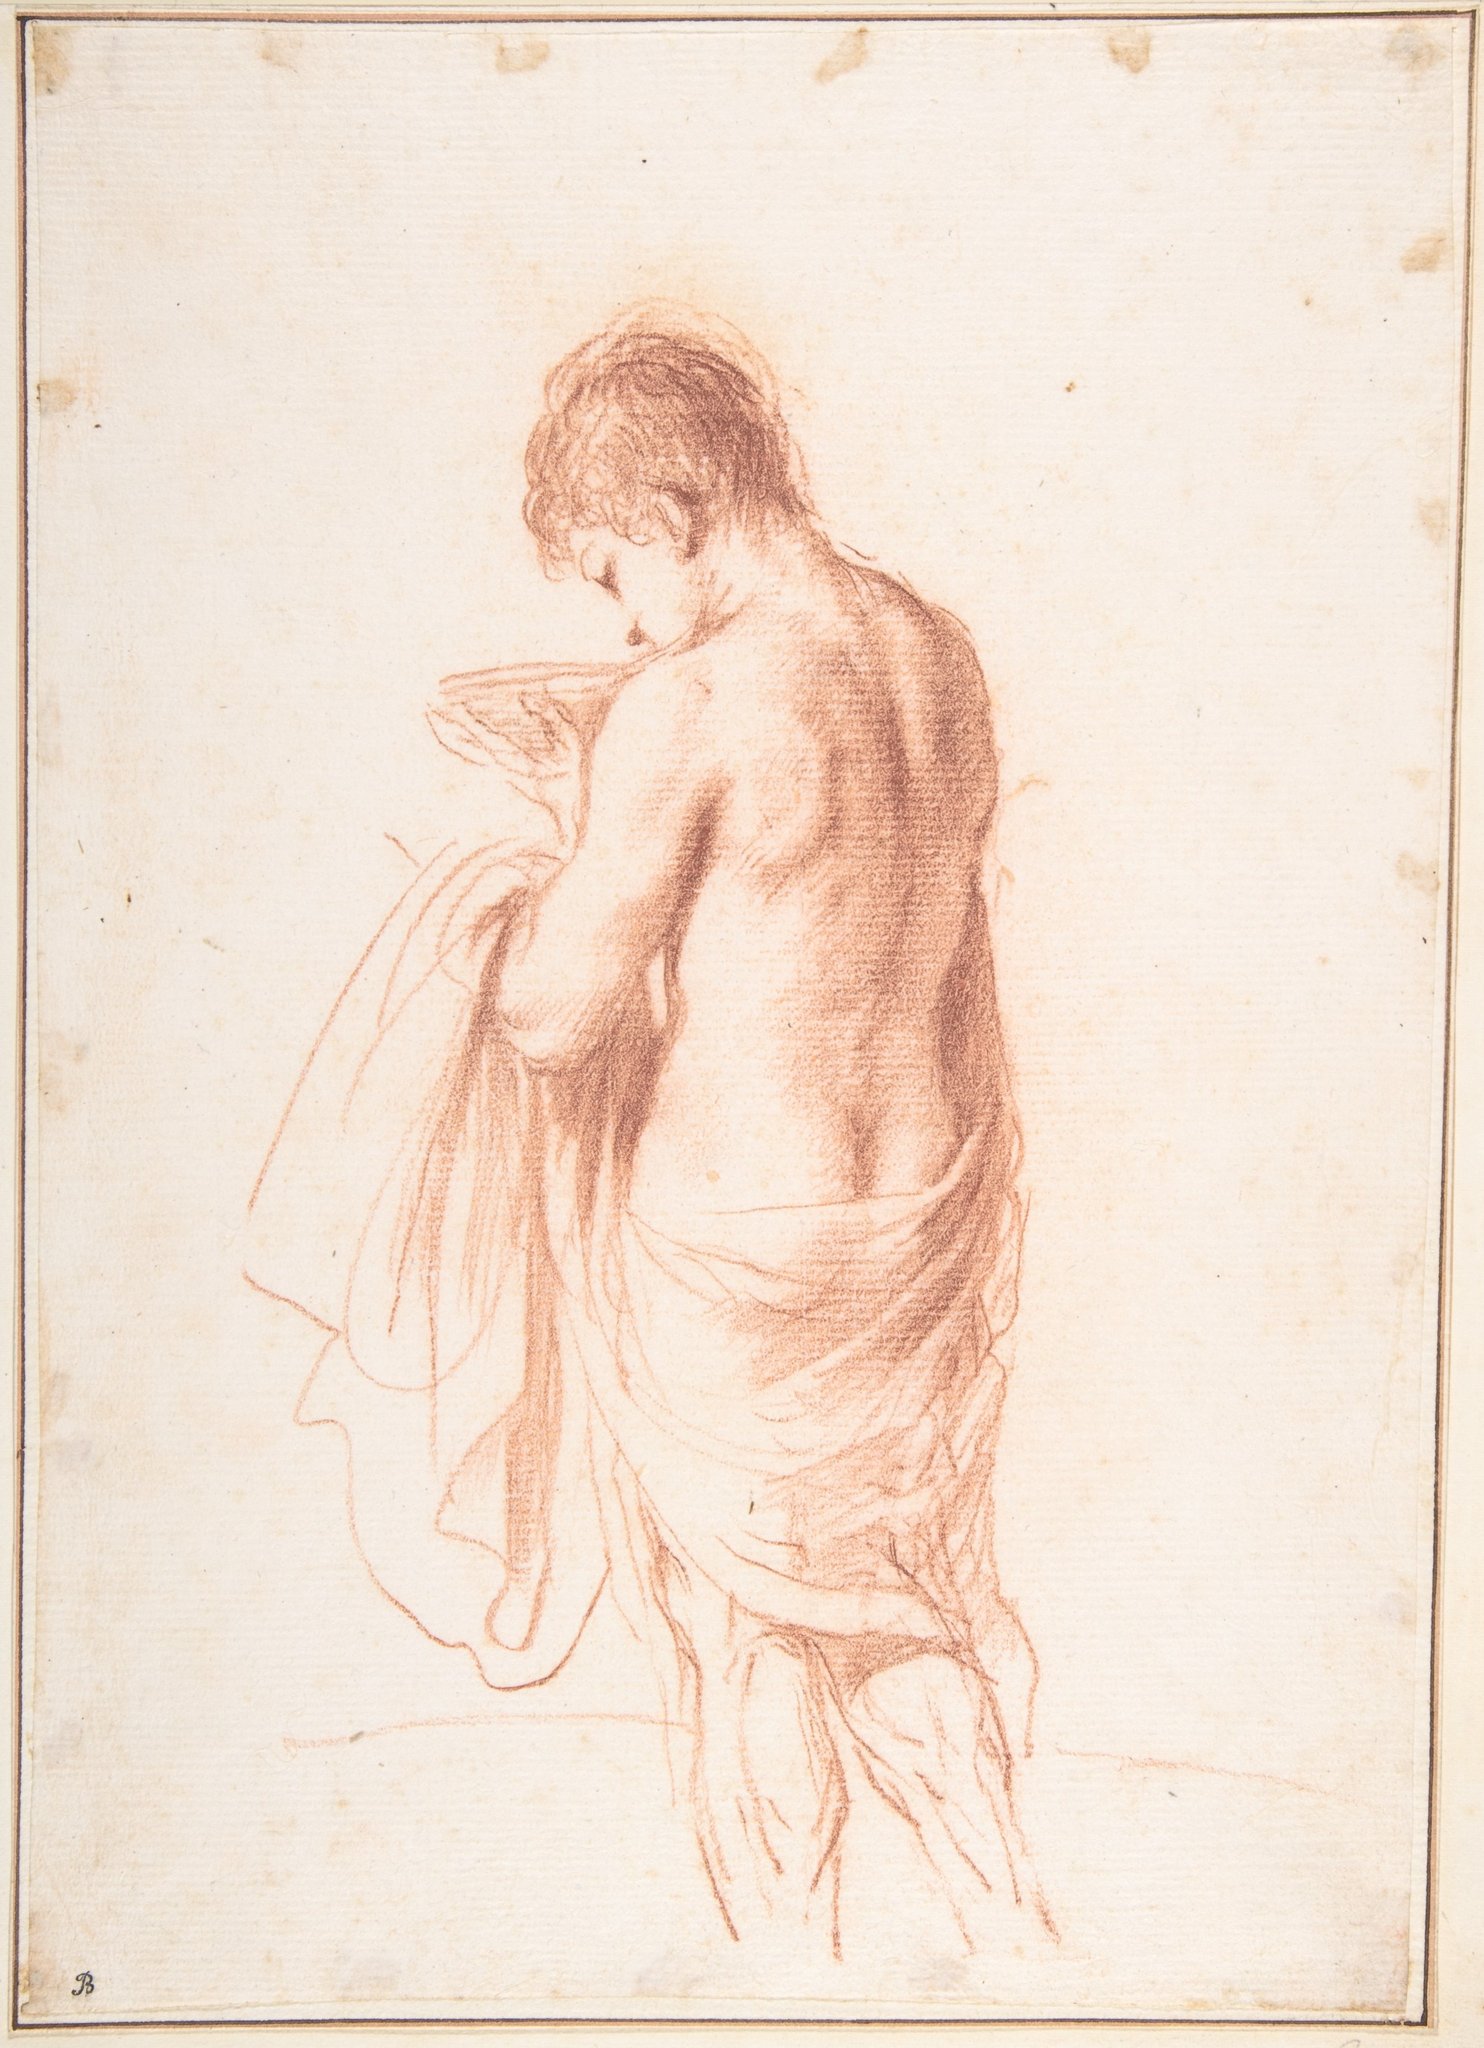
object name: drawing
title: Standing Youth Seen from Behind Holding a Bowl (Ganymede?)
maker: guercino (giovanni francesco barbieri)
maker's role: artist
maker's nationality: italian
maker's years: 1591-1666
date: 1635-1645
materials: chalk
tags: men,bowls